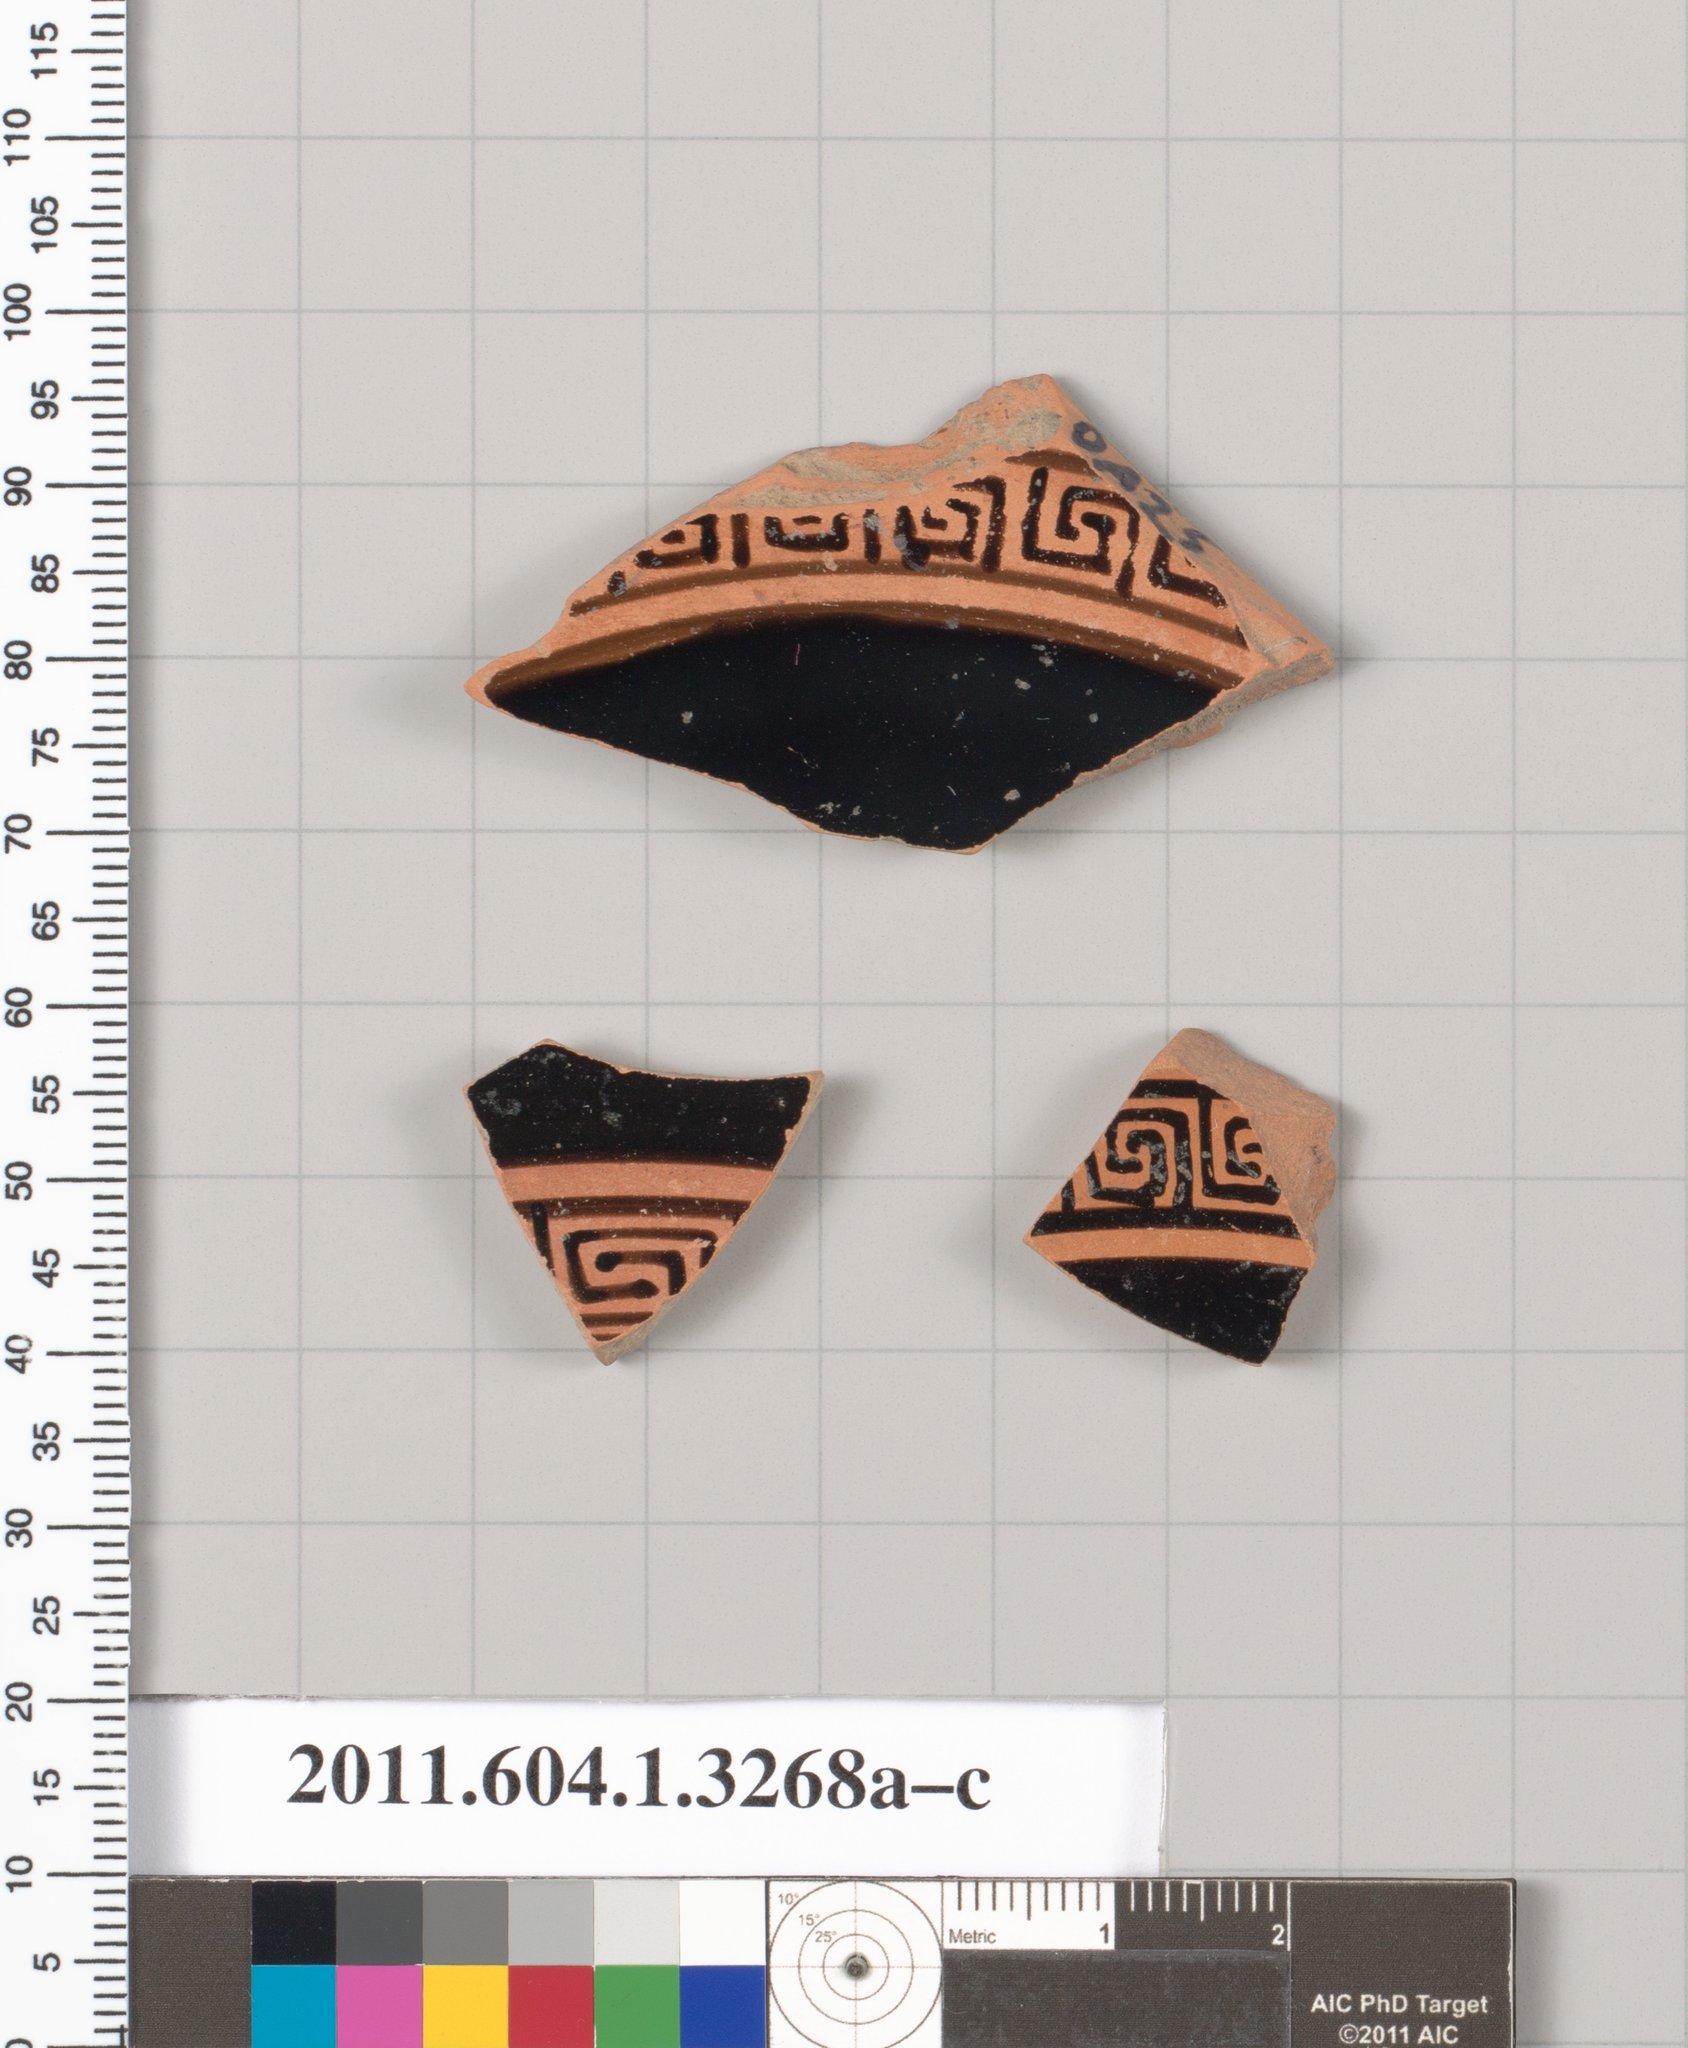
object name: kylix fragment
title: Terracotta fragments of kylikes (drinking cups)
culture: greek, attic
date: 500-490 BCE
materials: terracotta